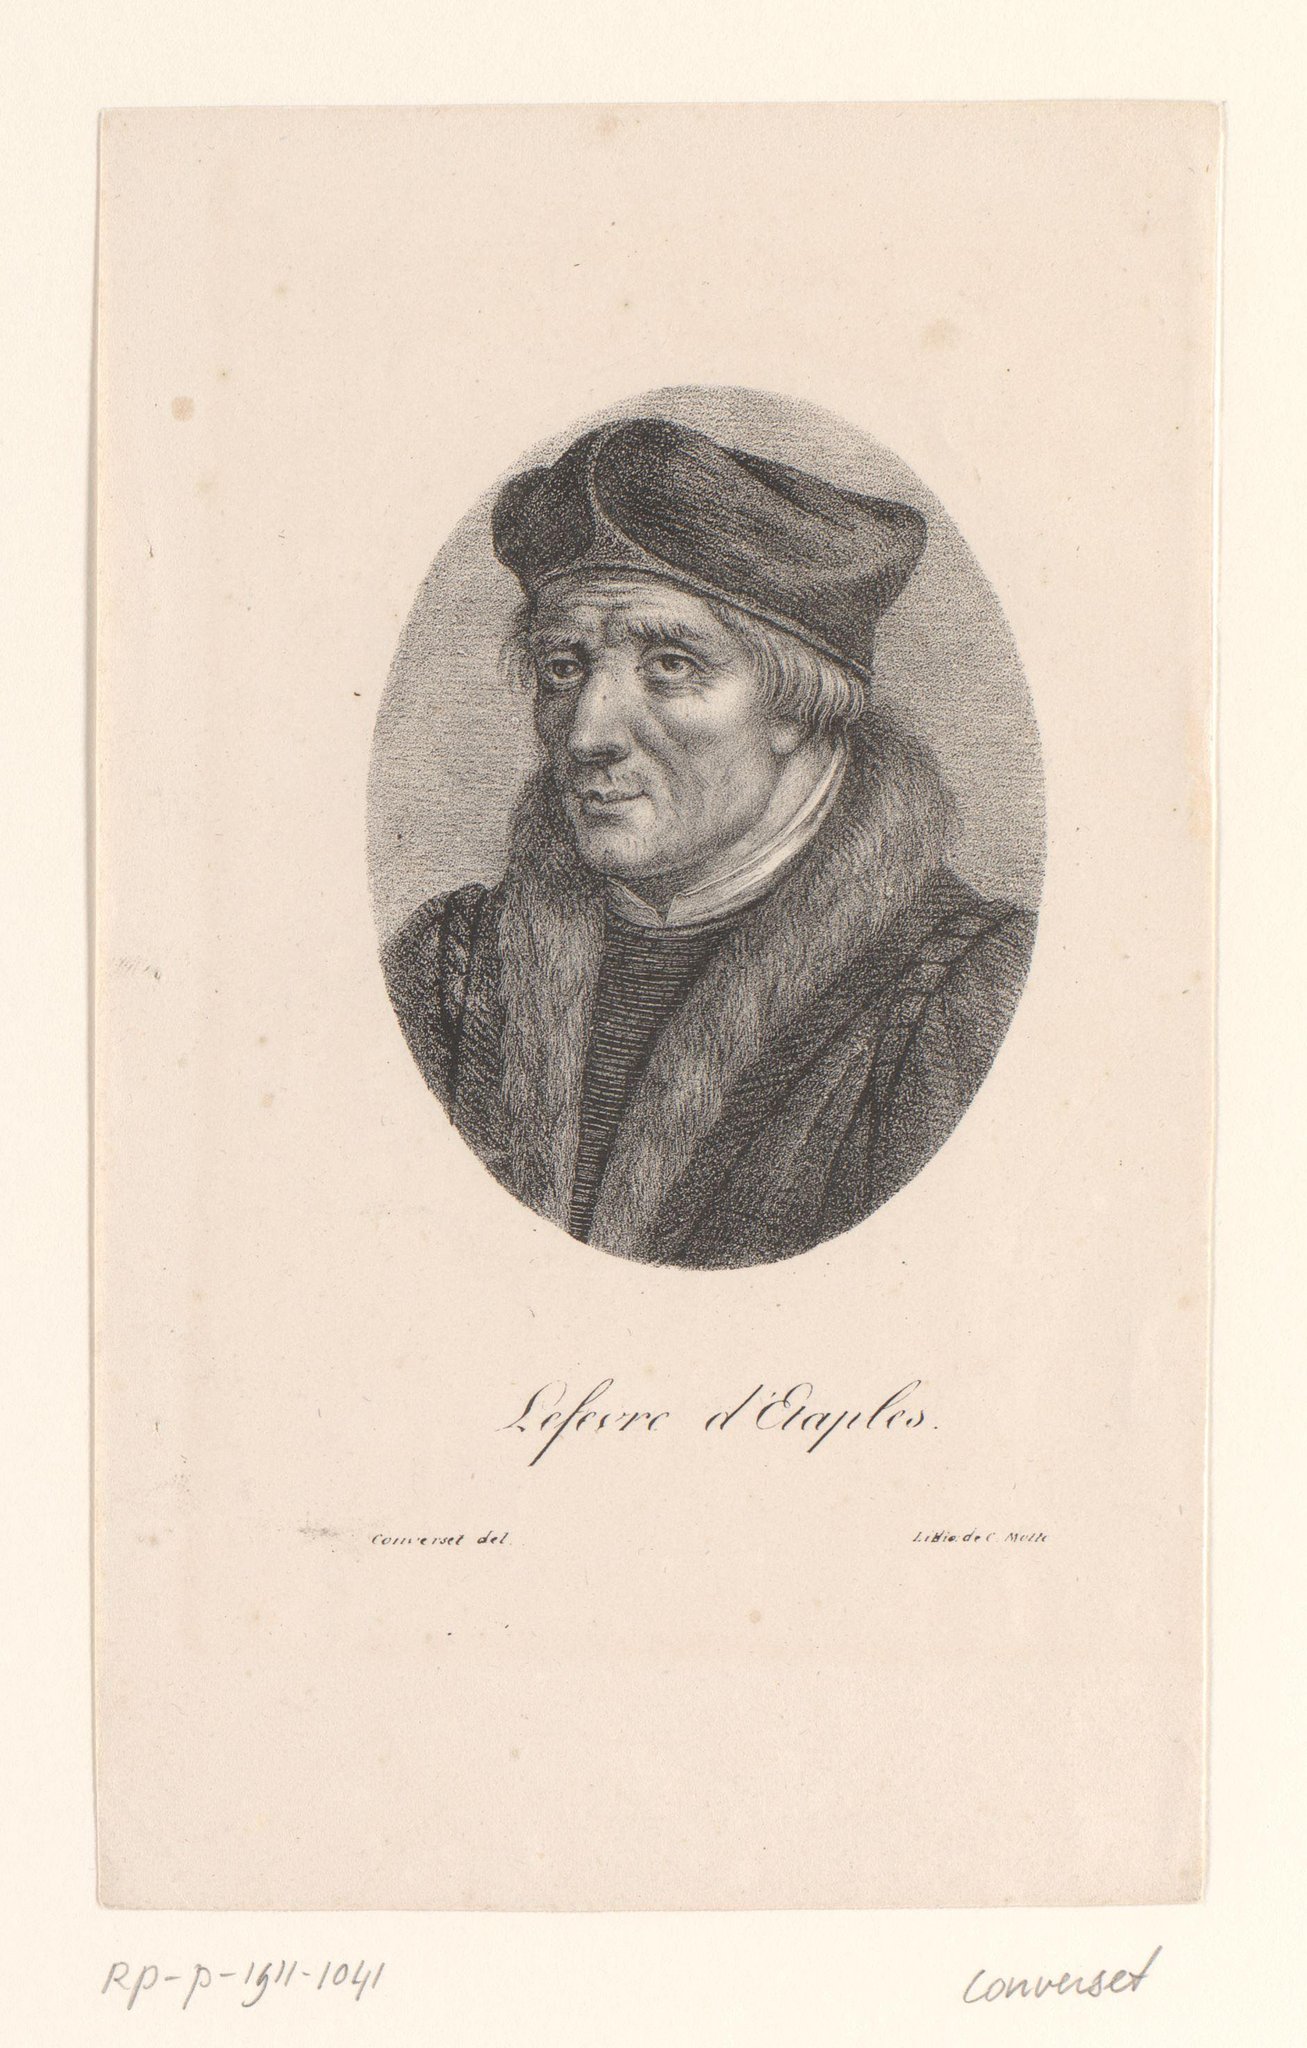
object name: print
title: Lefèvre d'Étaples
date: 1817-1836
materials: paper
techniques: lithograph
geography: paris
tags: historical persons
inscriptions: collector's mark: Lugt 2228a